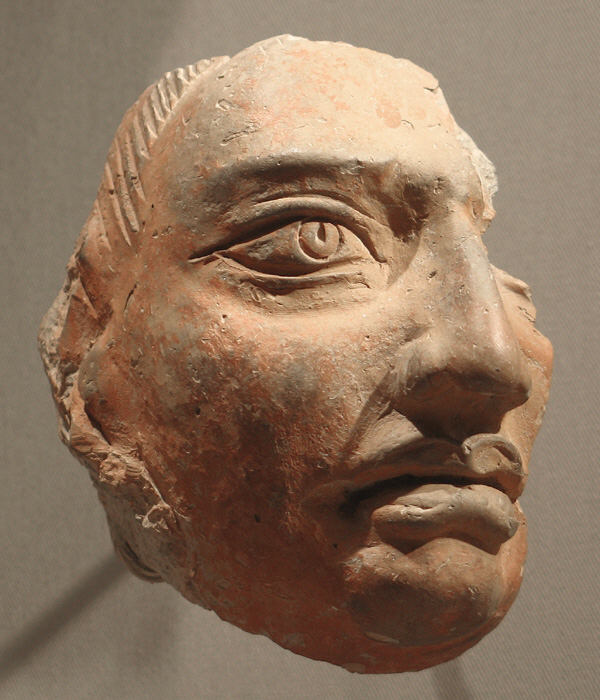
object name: head fragment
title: Head Fragment from a Plaque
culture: indian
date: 401-500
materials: terracotta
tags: gupta,heads